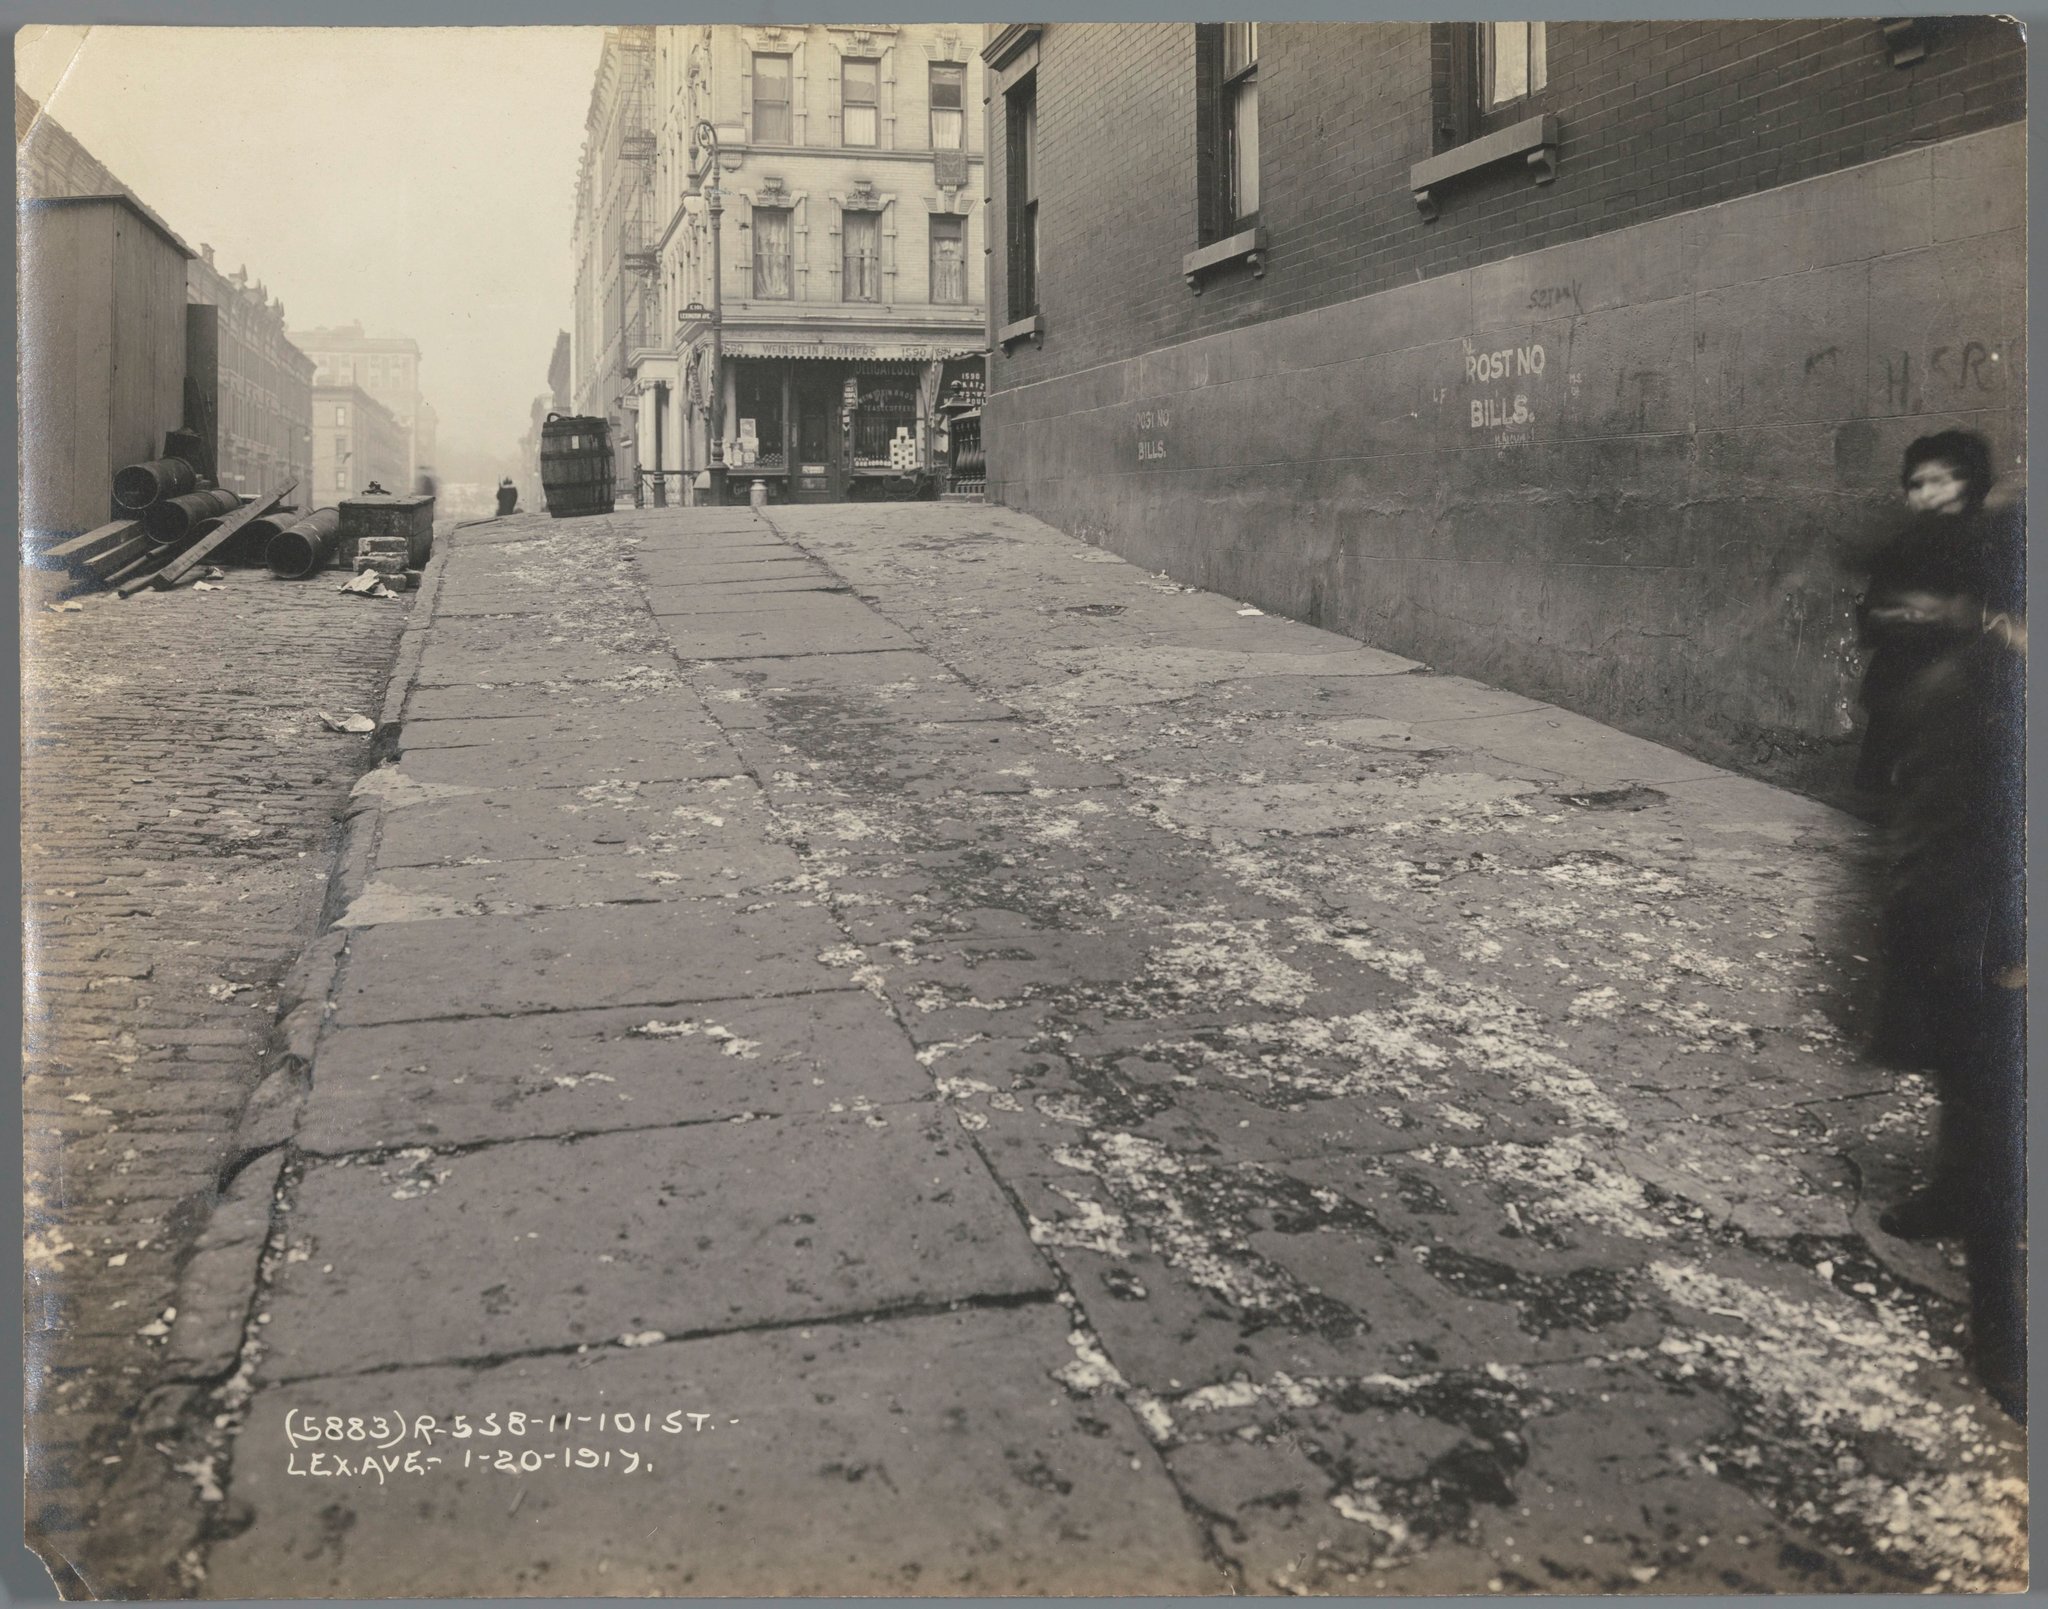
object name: photograph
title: Straatgezicht in New York, 1917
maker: Anonymous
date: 1917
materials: paper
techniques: gelatin silver print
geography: new york city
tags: street (+ city(-scape) with figures, staffage), new york (city)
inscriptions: inscription: ‘(5883) R-5S8-11-101 ST./ LEX.AVE-1-20-1917’